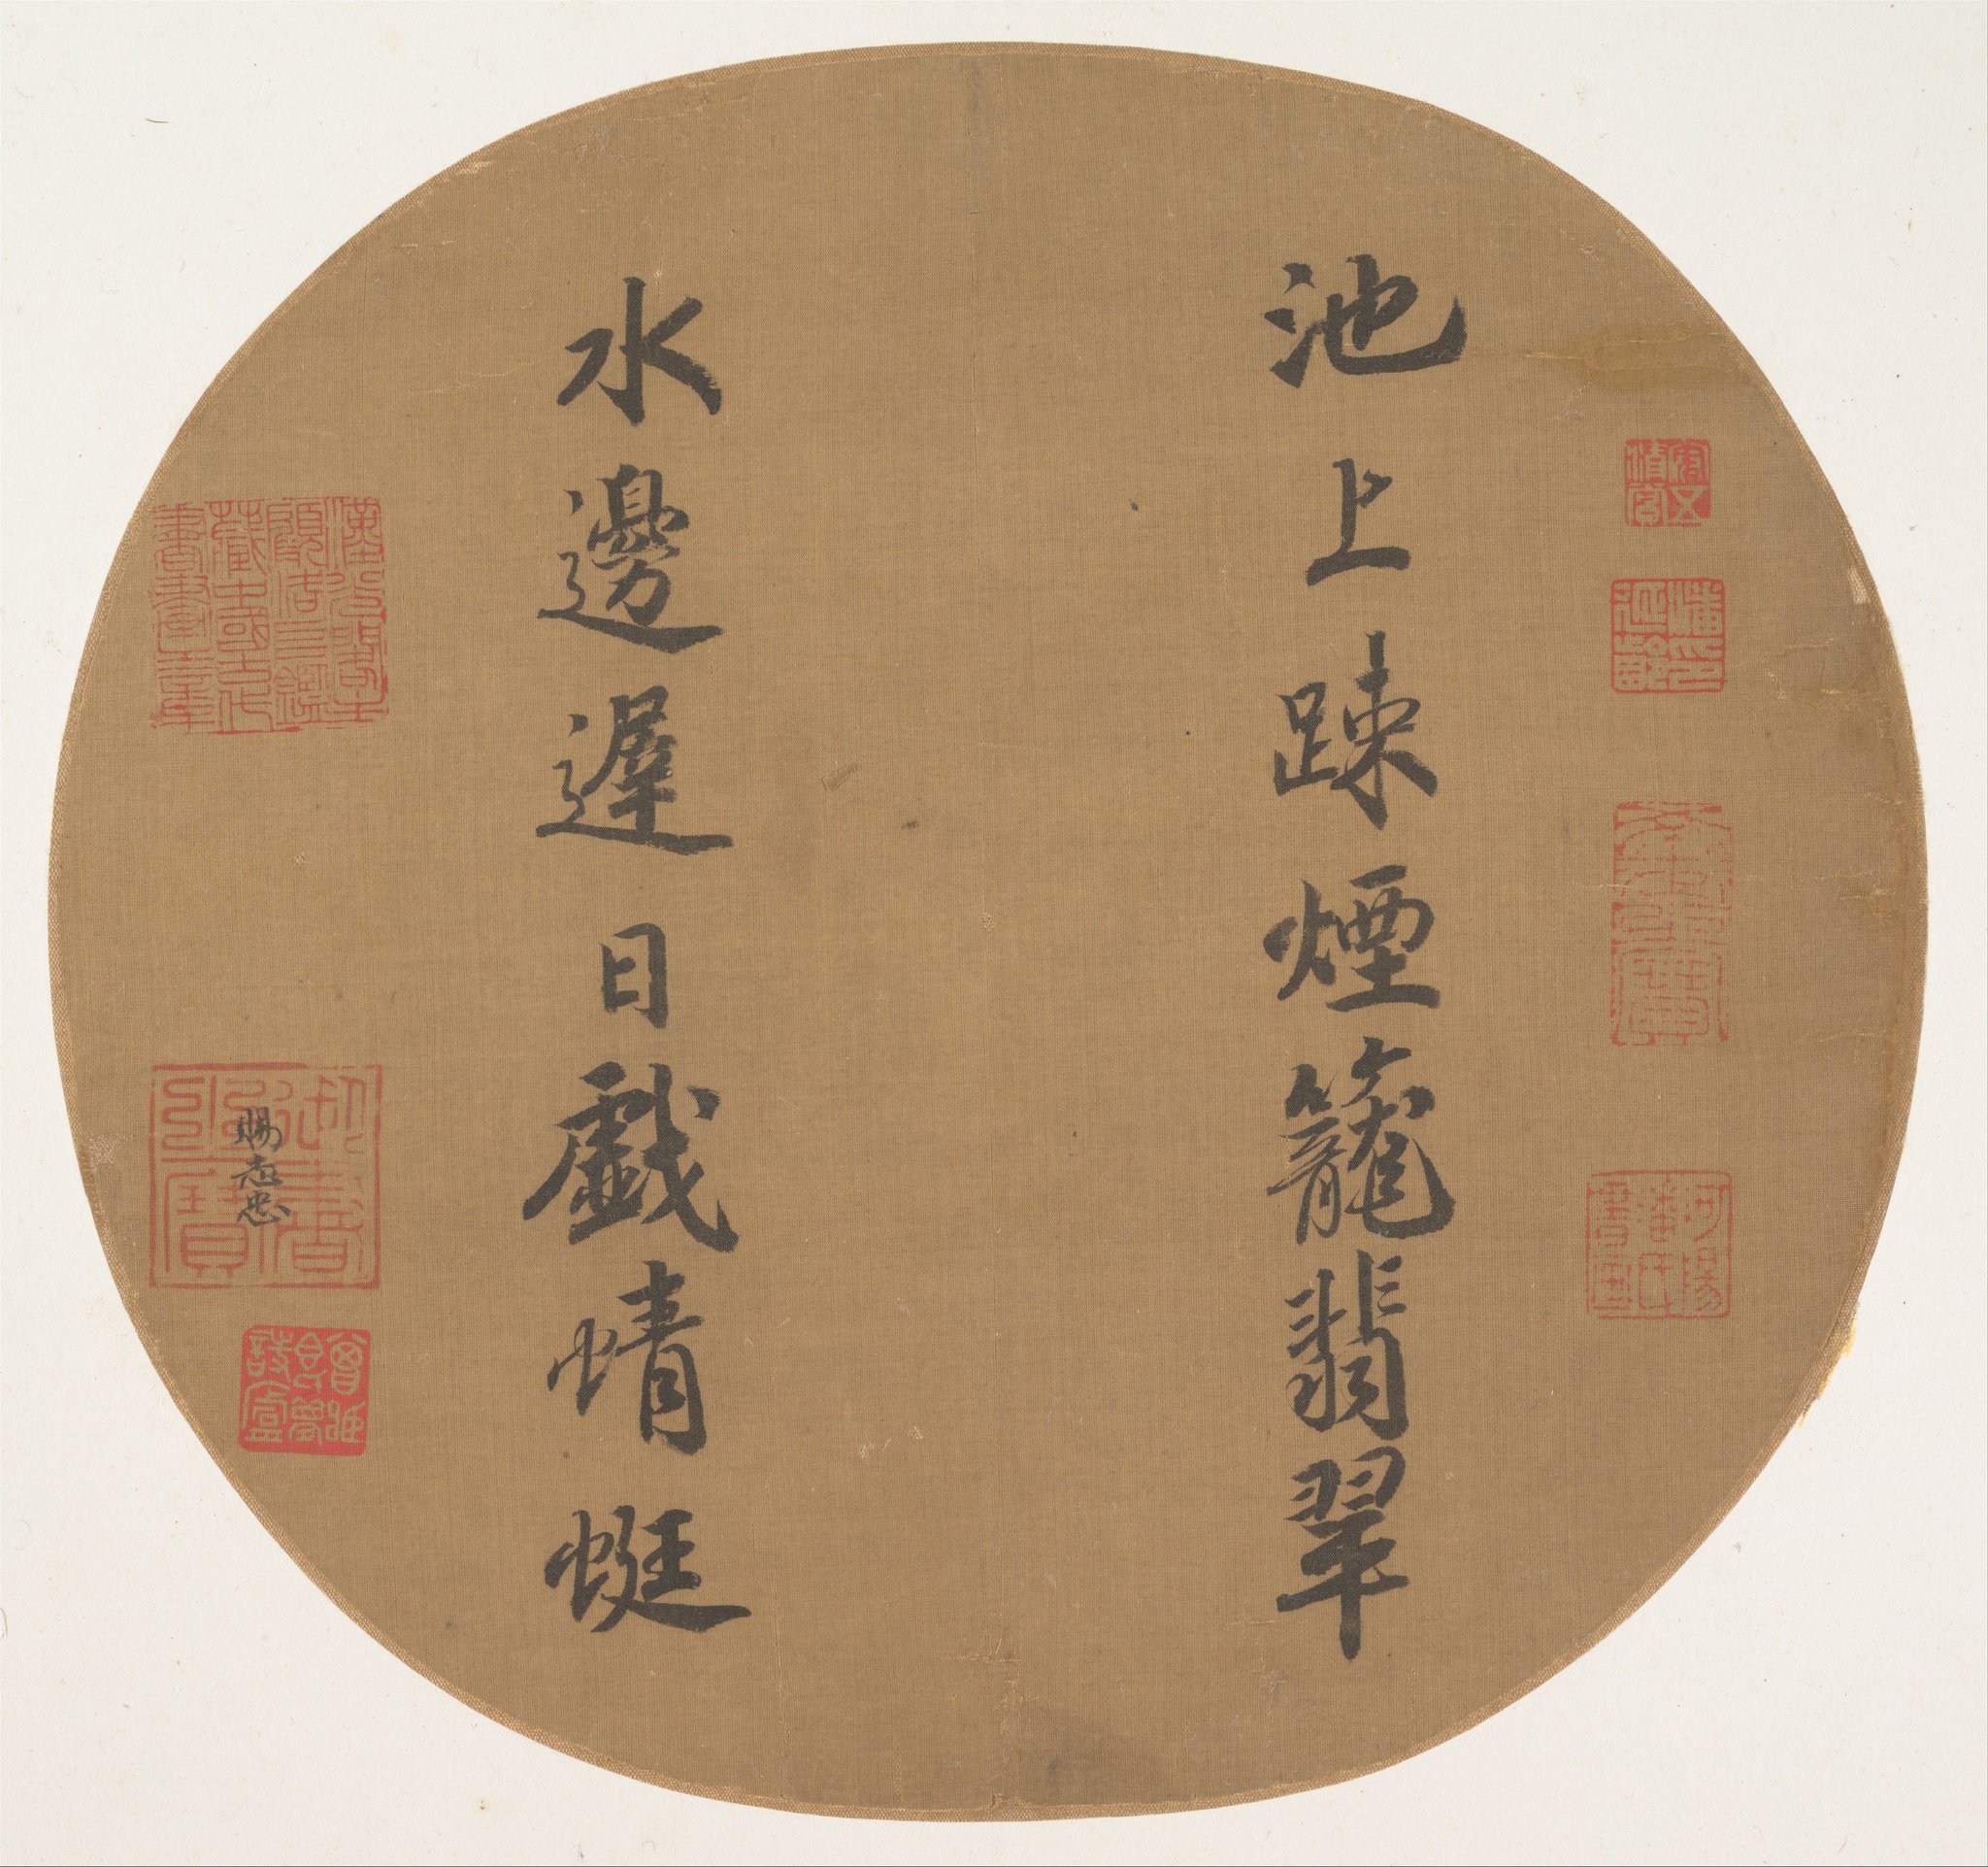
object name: fan mounted a an album leaf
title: Couplet on pond scenery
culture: chinese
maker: emperor xiaozong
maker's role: artist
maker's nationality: chinese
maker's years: 1127-1194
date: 1101-1200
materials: ink, silk